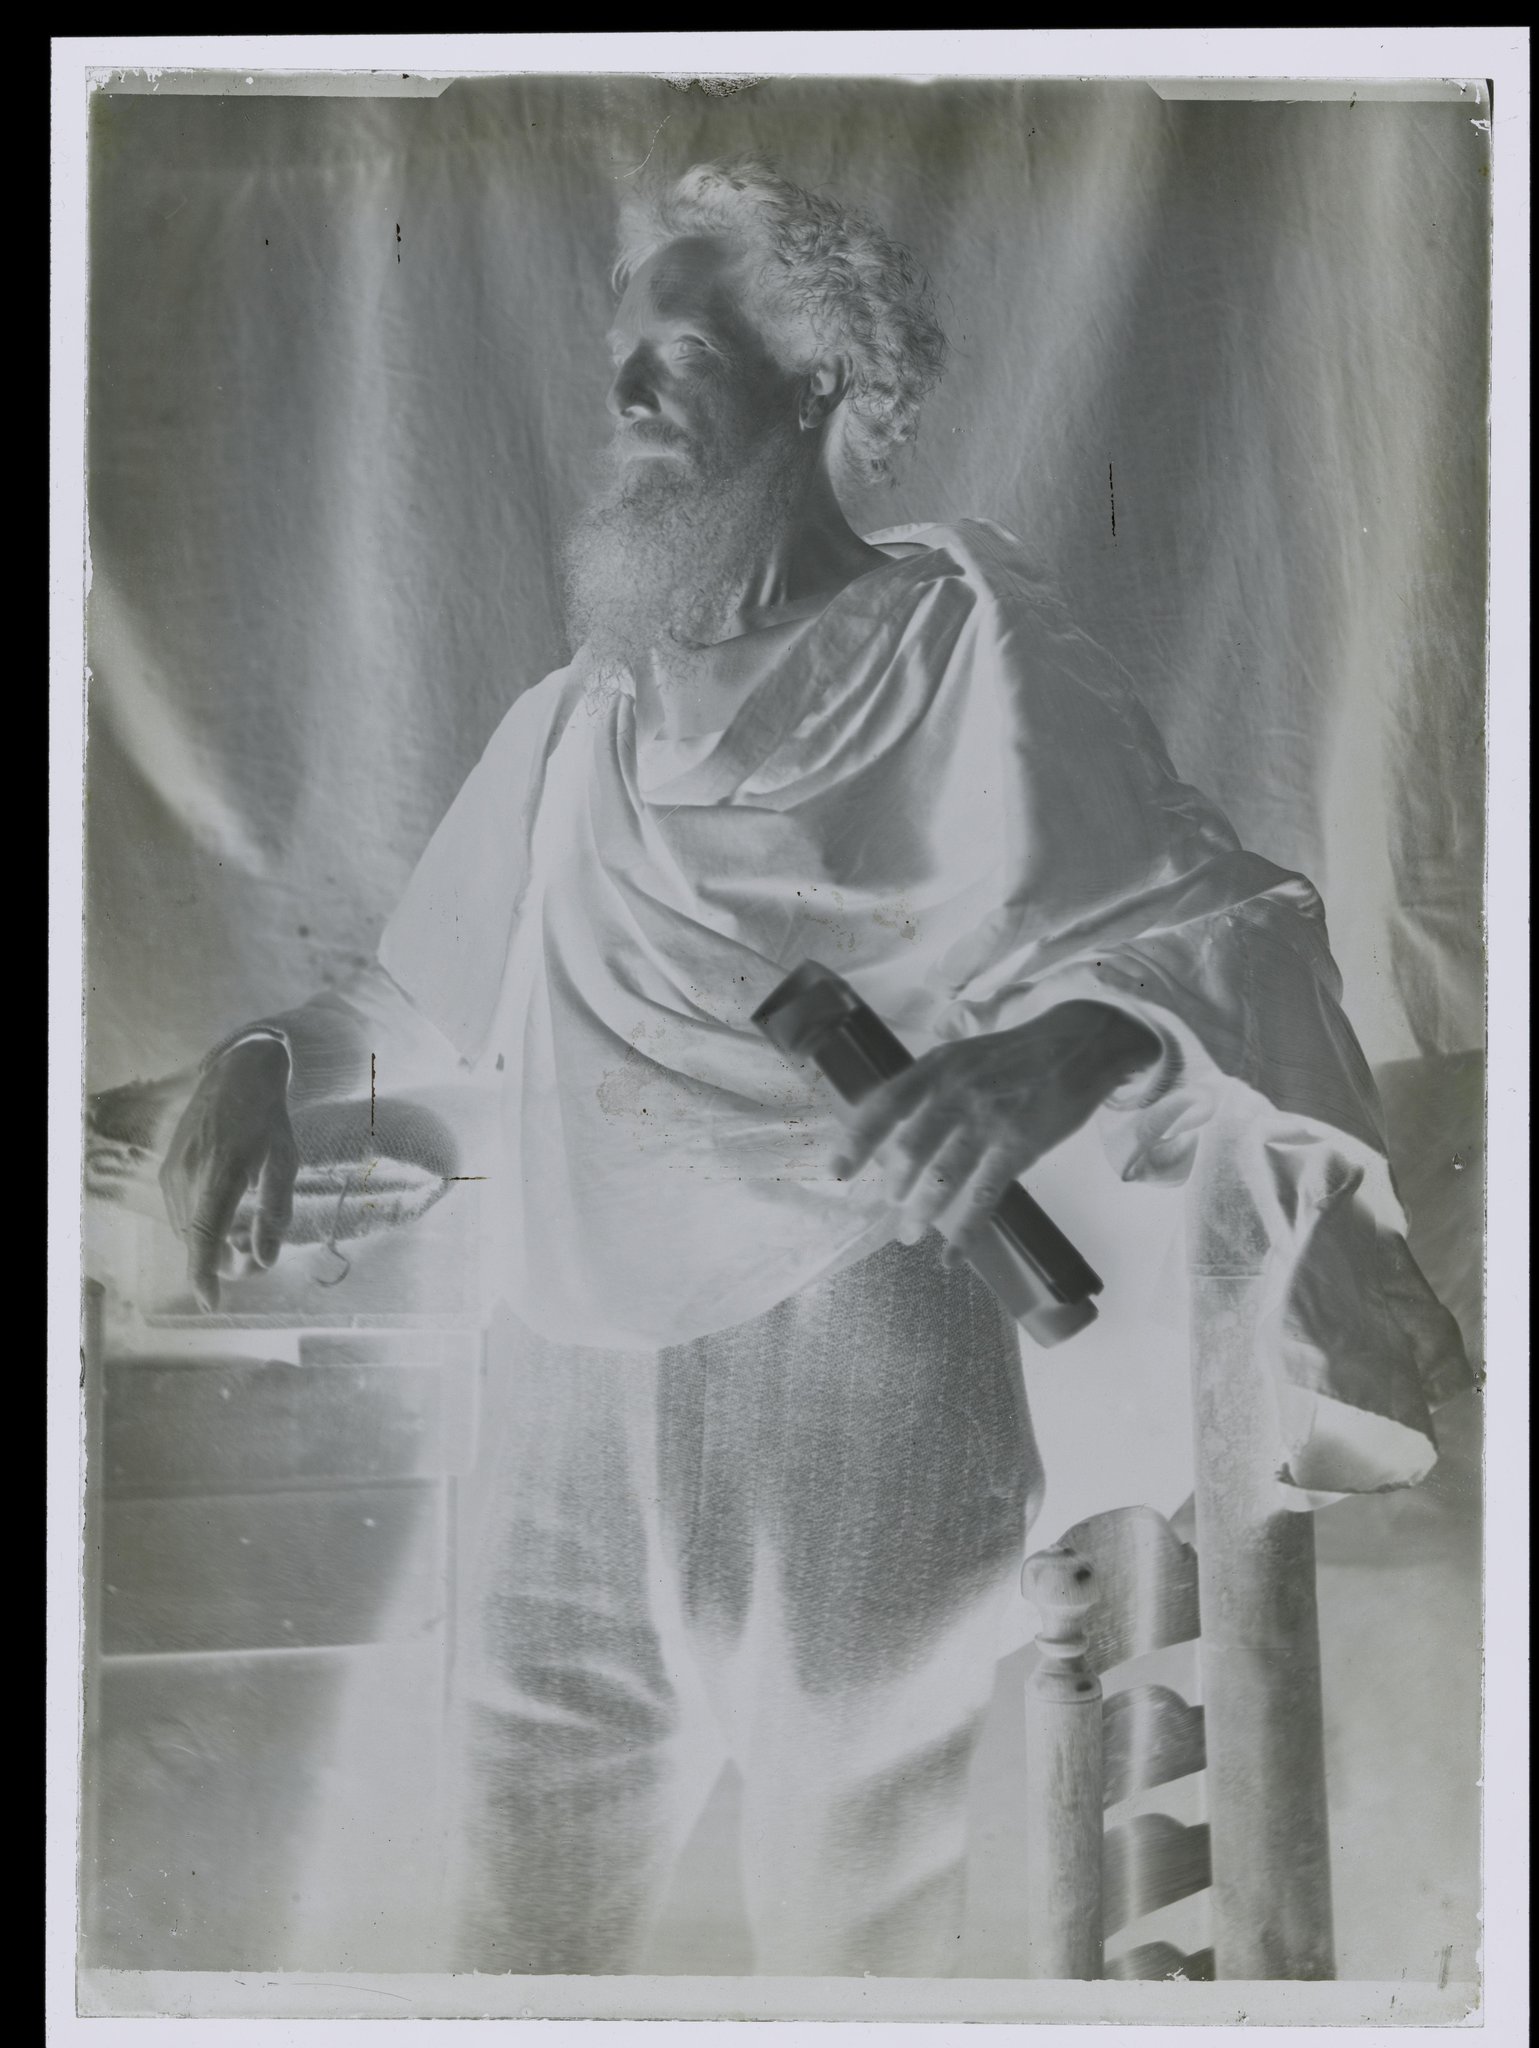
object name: glasnegatief, glasplaatnegatief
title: Laurens Lodewijk Kleijn als de apostel Paulus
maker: laurens lodewijk kleijn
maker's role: draughtsman, painter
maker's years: 1826-1909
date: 1865-1900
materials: glass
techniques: collodion process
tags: painter, draughtsman, laurens lodewijk kleijn, portrait, self-portrait of photographer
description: Onderdeel van een groep glasnegatieven uit de nalatenschap van de schilder Laurens Lodewijk Kleijn, met stillevens, portretten, zelfportretten en kunstreproducties.